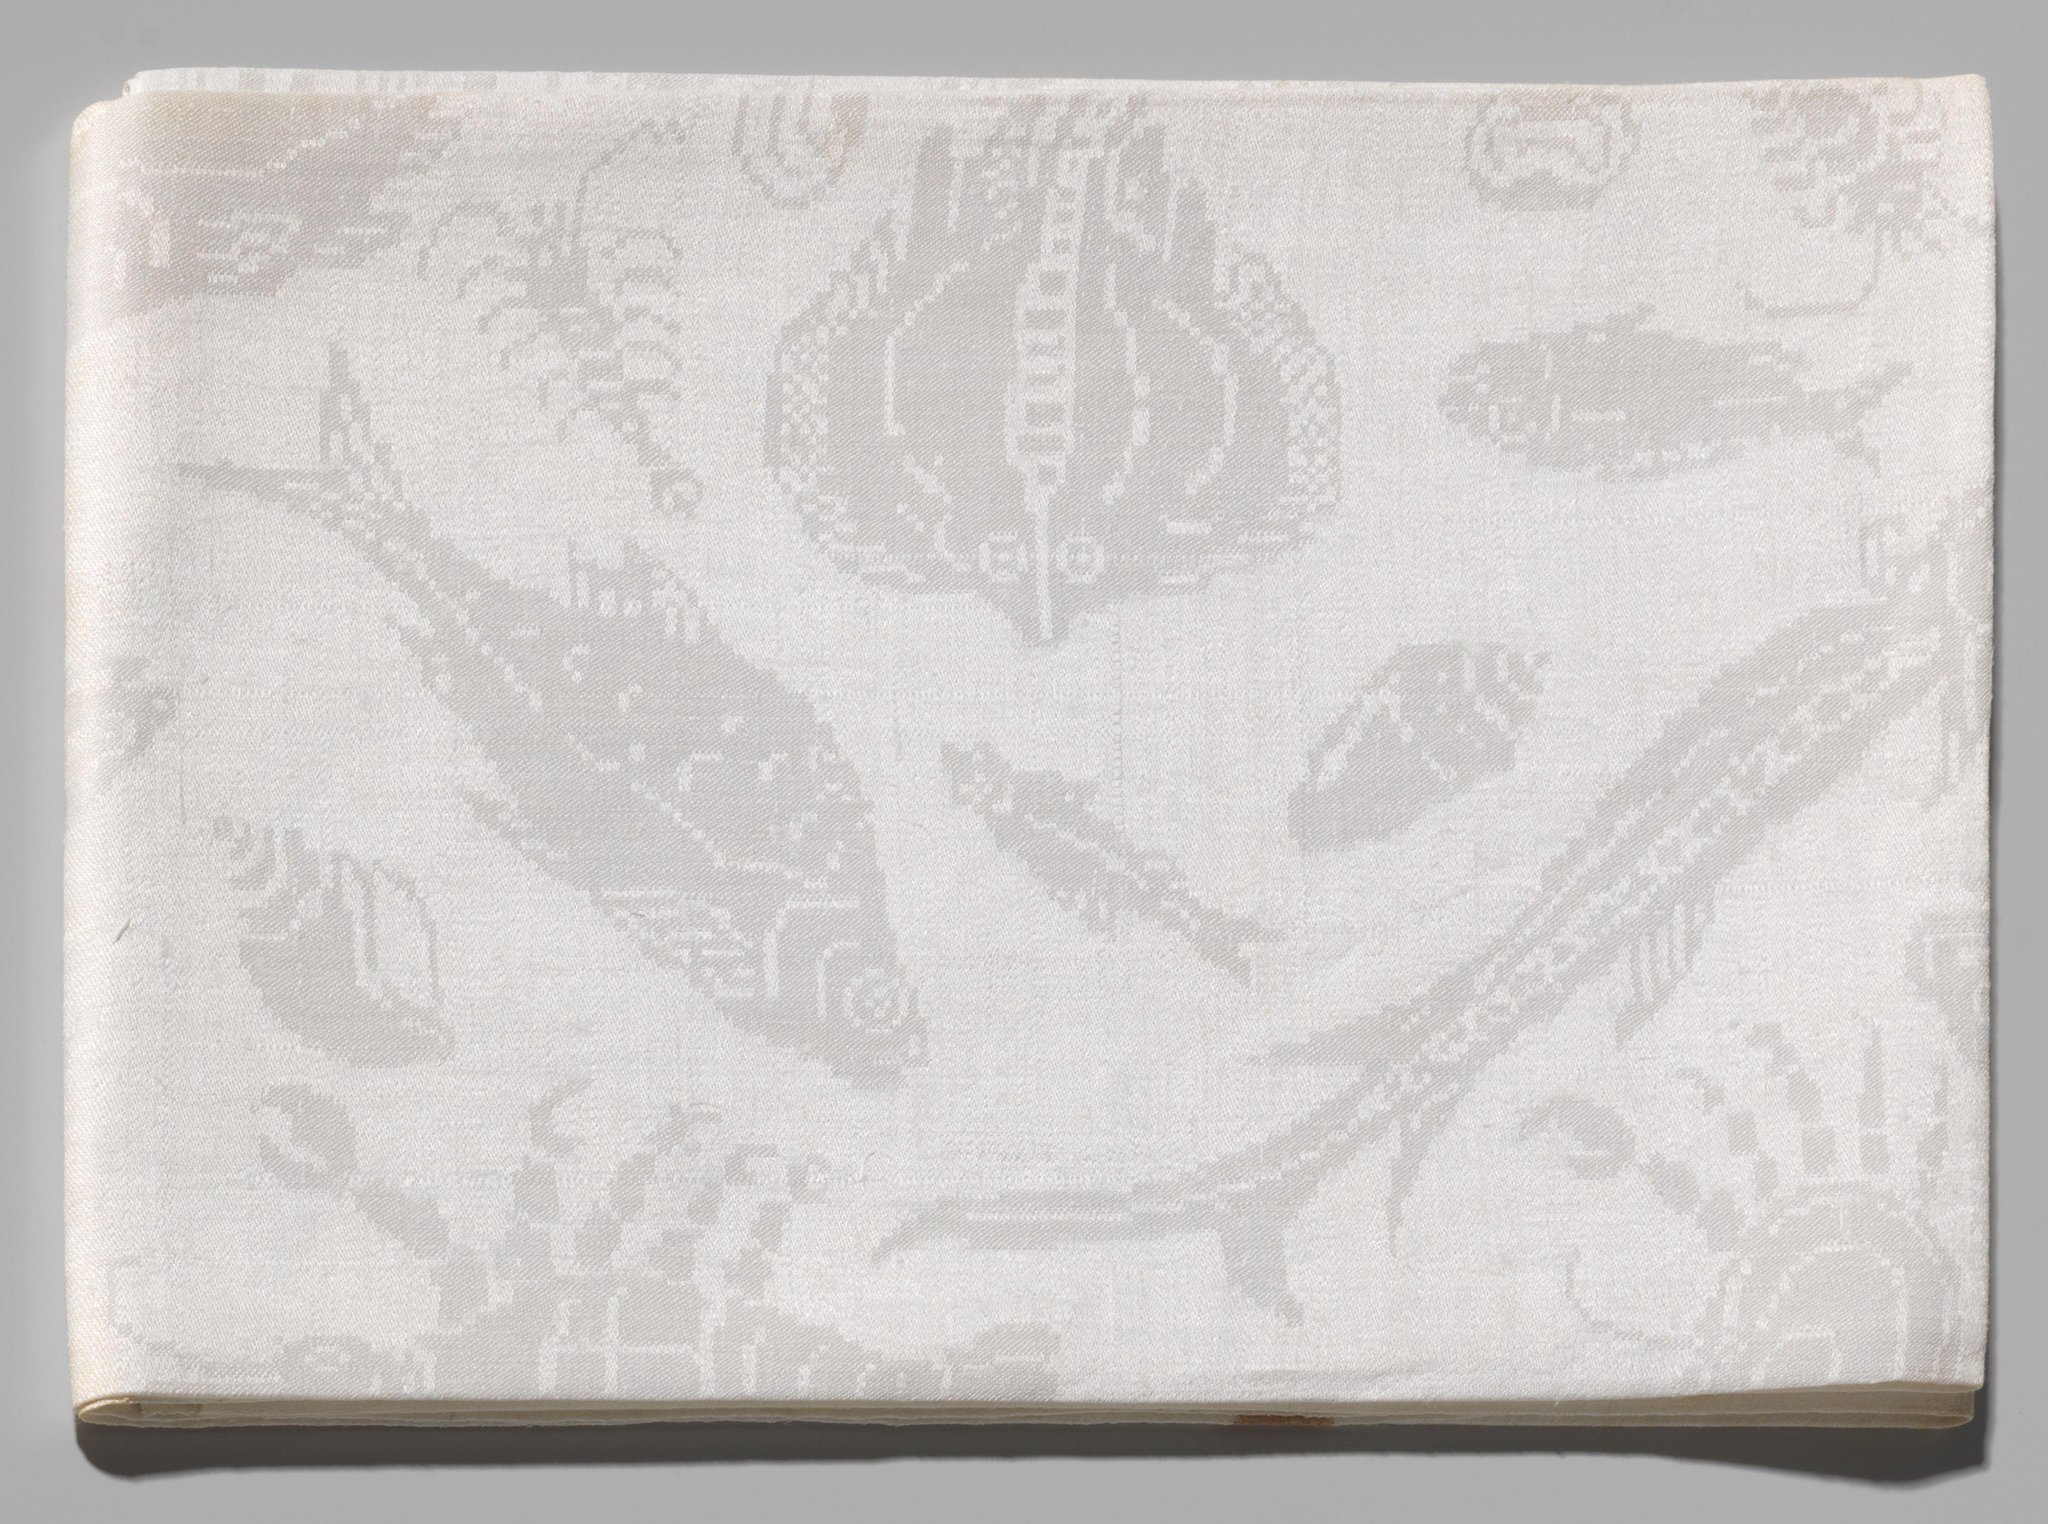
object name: napkin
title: Servet met vissen en schaaldieren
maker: Anonymous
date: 1600-1649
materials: linen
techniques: damask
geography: haarlem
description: Servet van linnendamast met vissen en schaaldieren. Middenveld: diverse vissen. Staande randen: vissen en visvangst. Liggende randen: zeegoden. Hoek: krab.